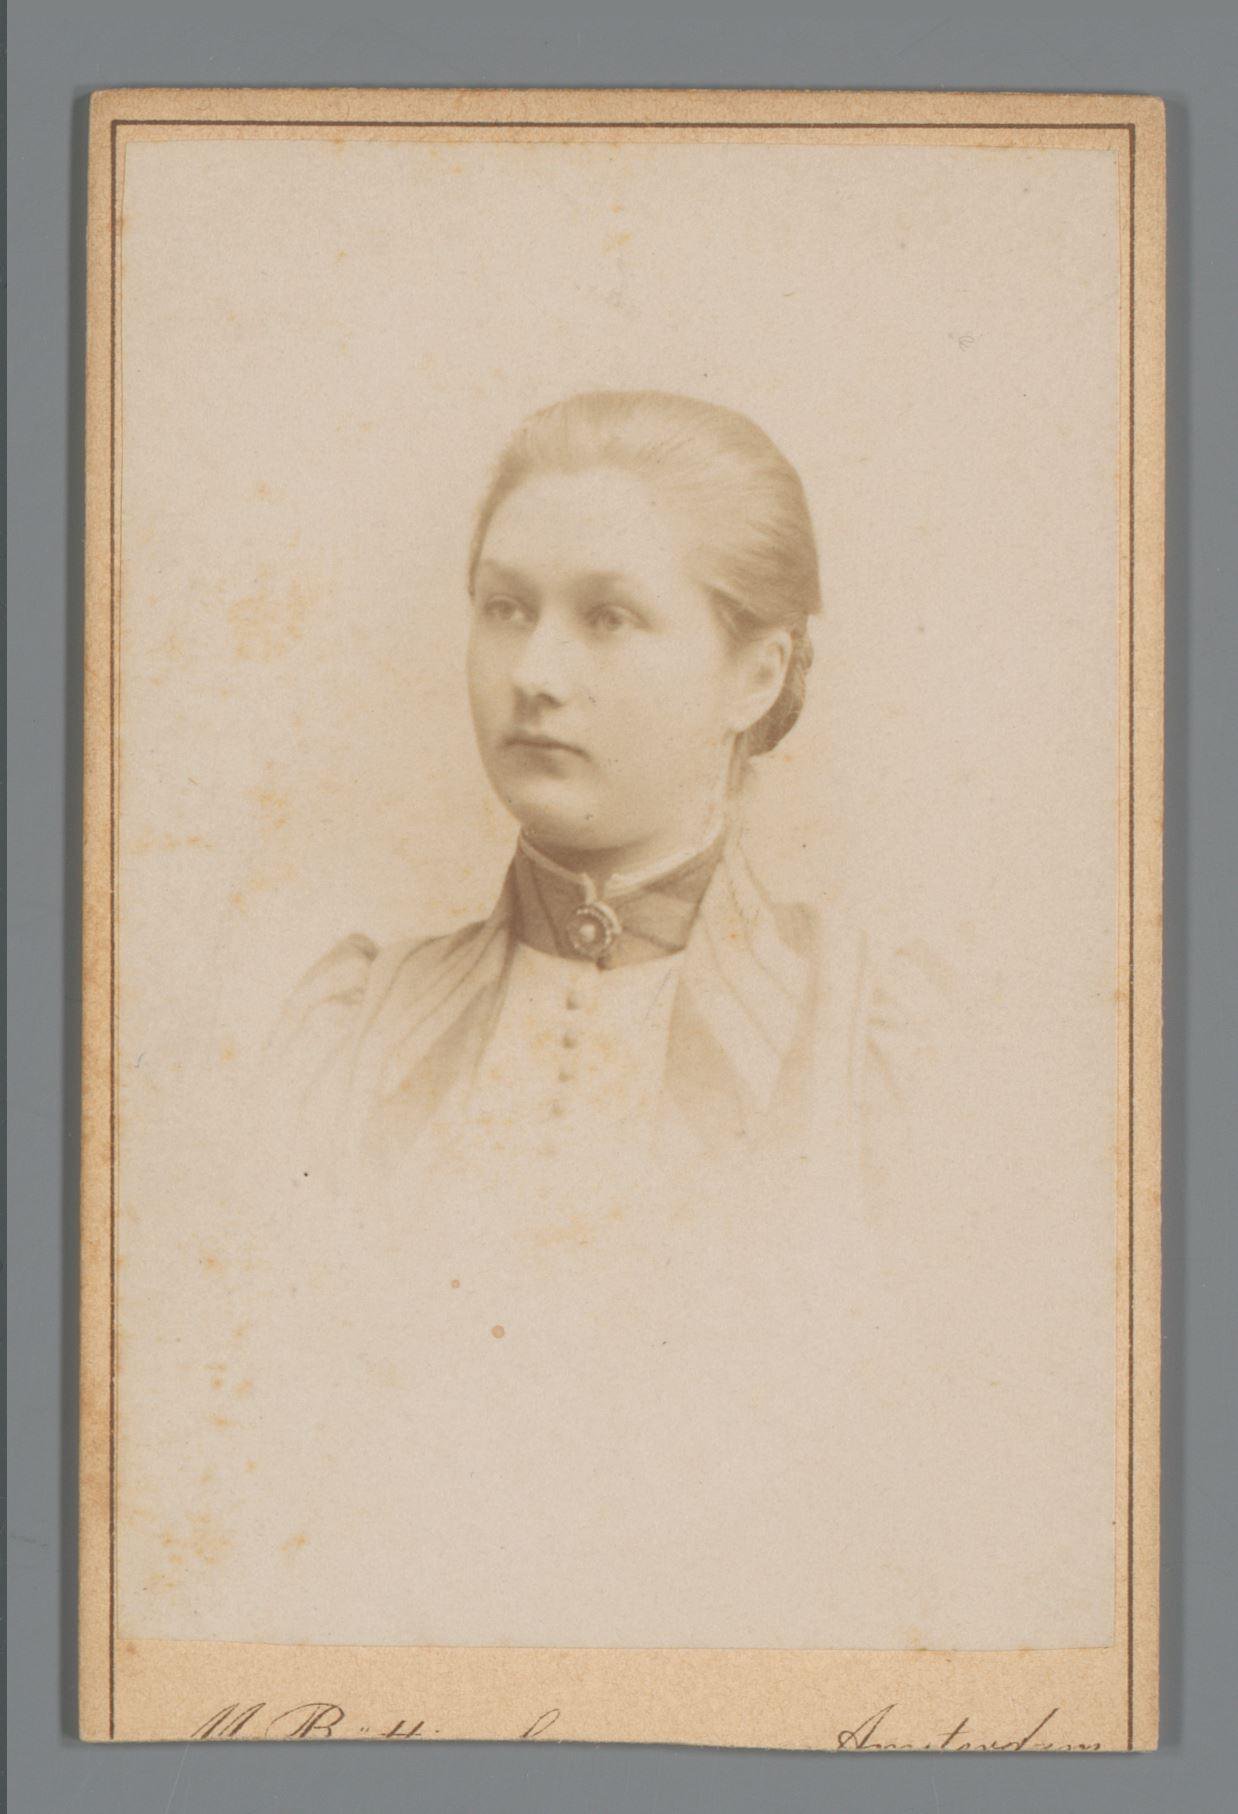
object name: photograph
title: Portret van Johanna Geertruida Jonker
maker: max büttinghausen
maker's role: fotograaf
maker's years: 1847-1906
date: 1873-1906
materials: cardboard, photographic support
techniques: albumen print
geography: amsterdam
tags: historical persons, amsterdam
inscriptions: annotation: ‘Jo Jonker’, workshop stamp: ‘M. Büttinghausen/ Photographisch artistisch Atelier/ Amsterdam, Kalverstraat hoek Spui/ Amsterdam 1877’